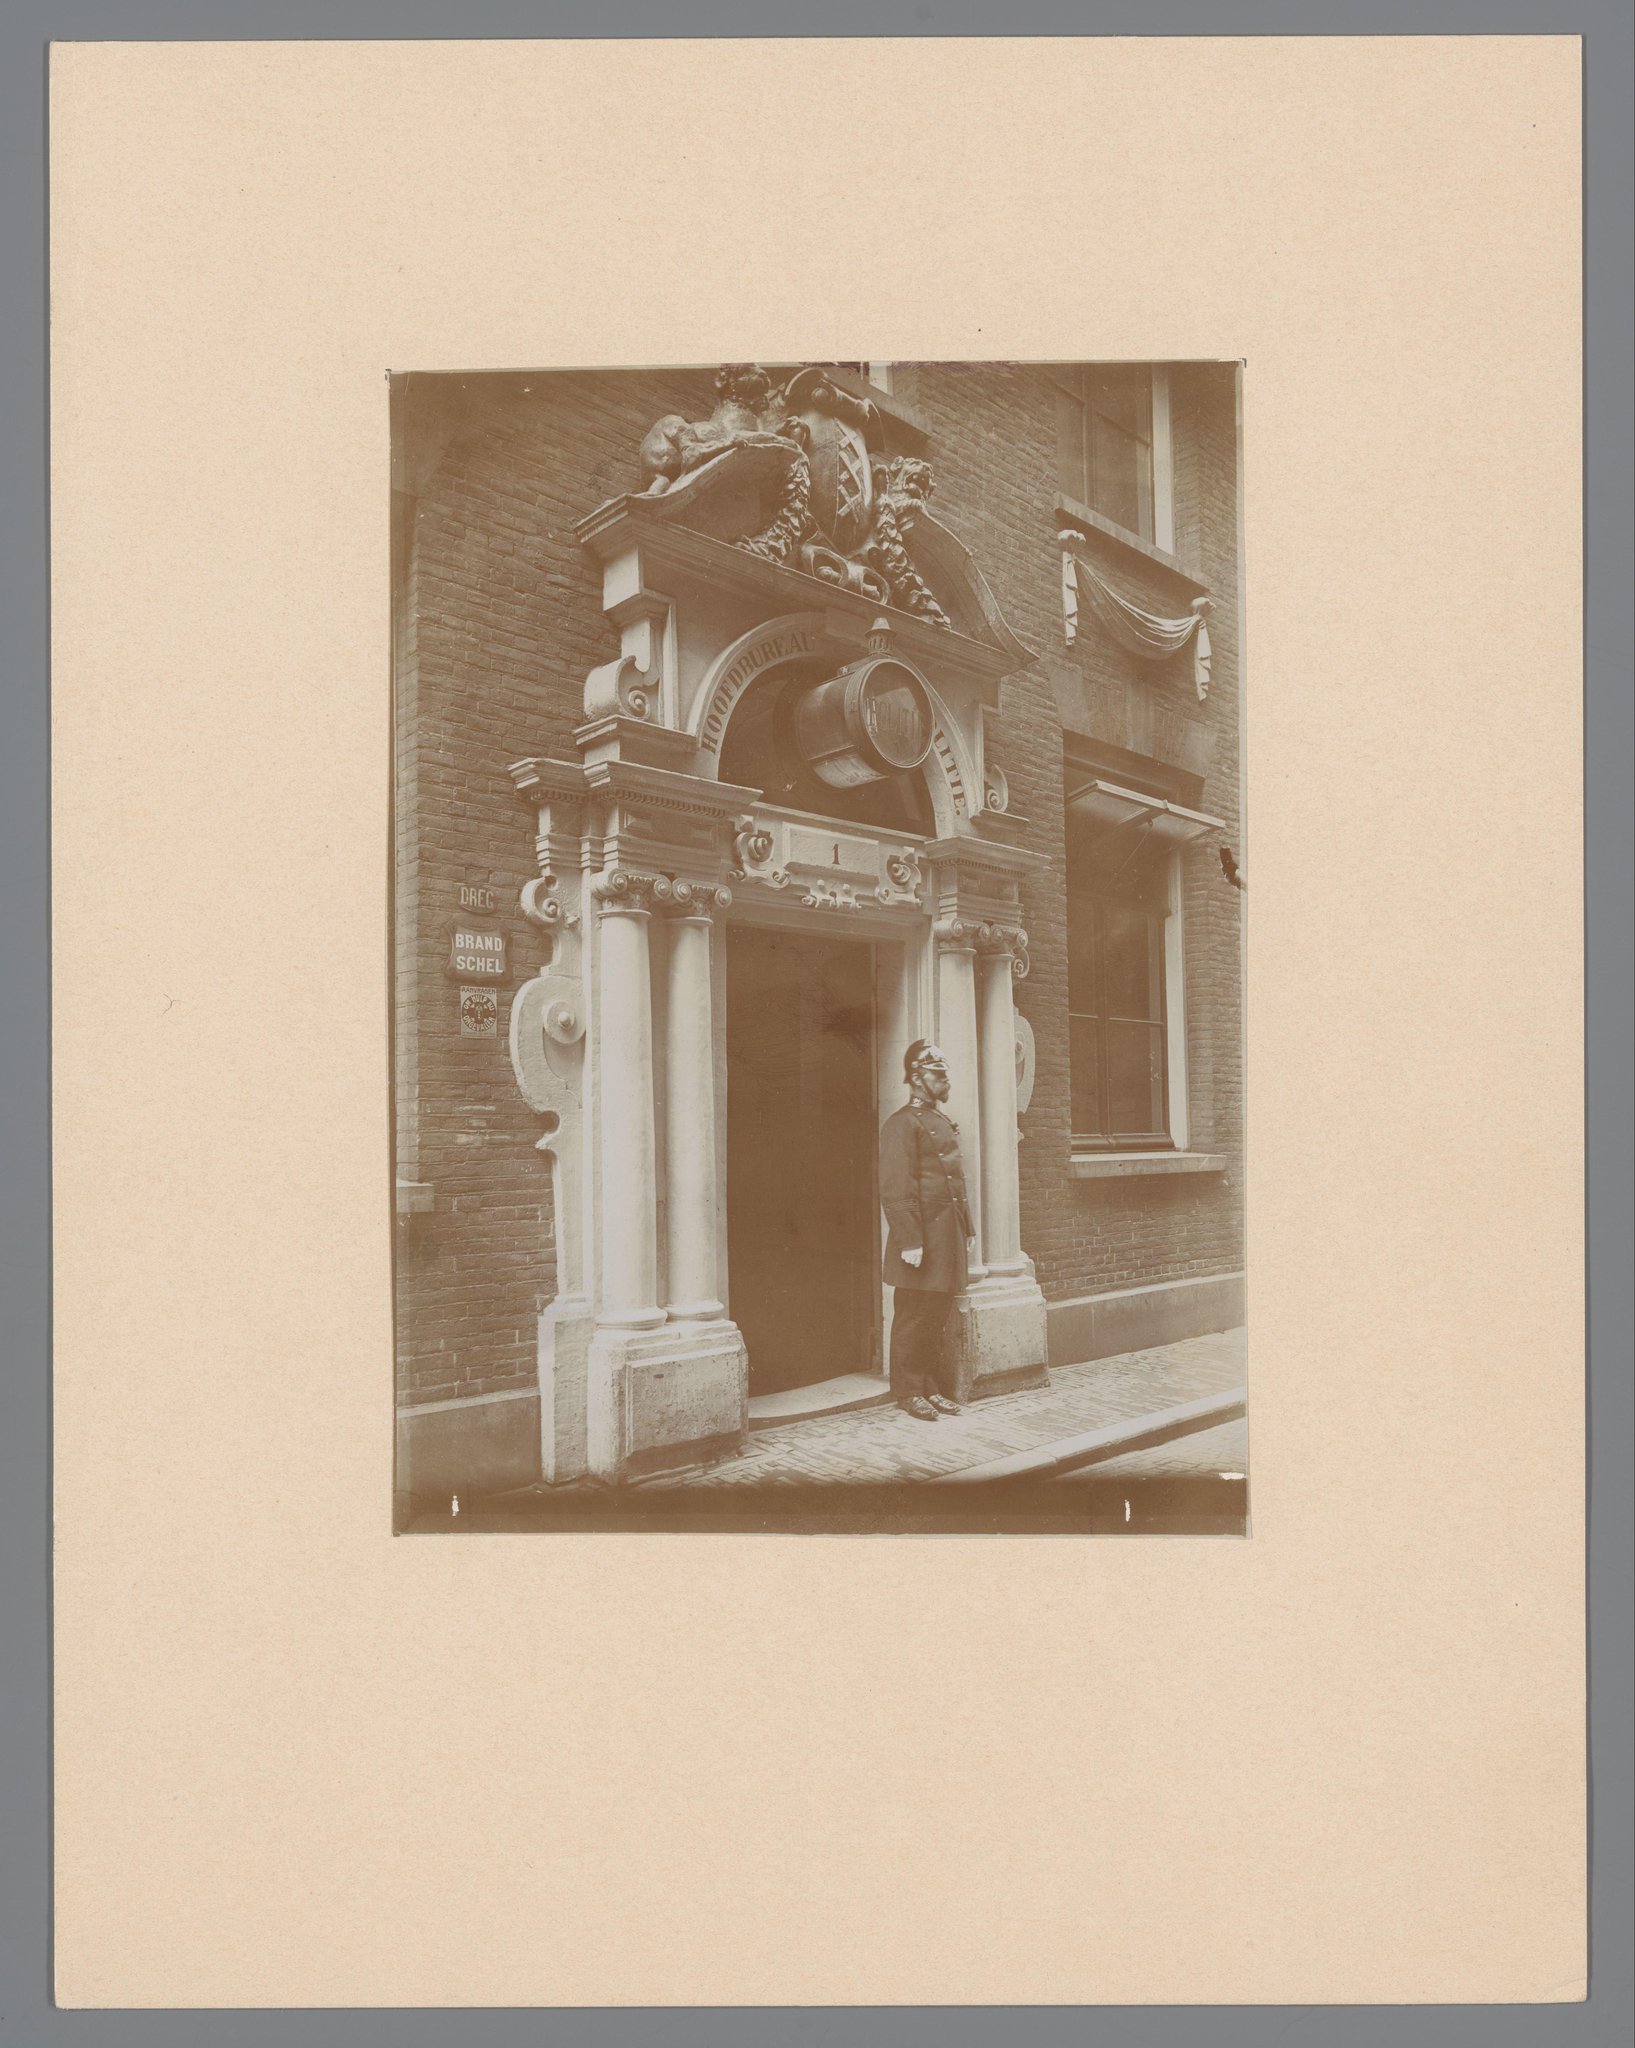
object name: photograph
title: Poort van het Spinhuis, nu aangebracht in het nieuwe politiebureau in de Spinhuissteeg te Amsterdam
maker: Anonymous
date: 1910-1920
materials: cardboard, photographic support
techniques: gelatin silver print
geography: amsterdam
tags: policeman, constable, gate, entrance, civic architecture; edifices; dwellings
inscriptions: annotation: ‘Spinhuis’, collector's mark: Lugt 2166